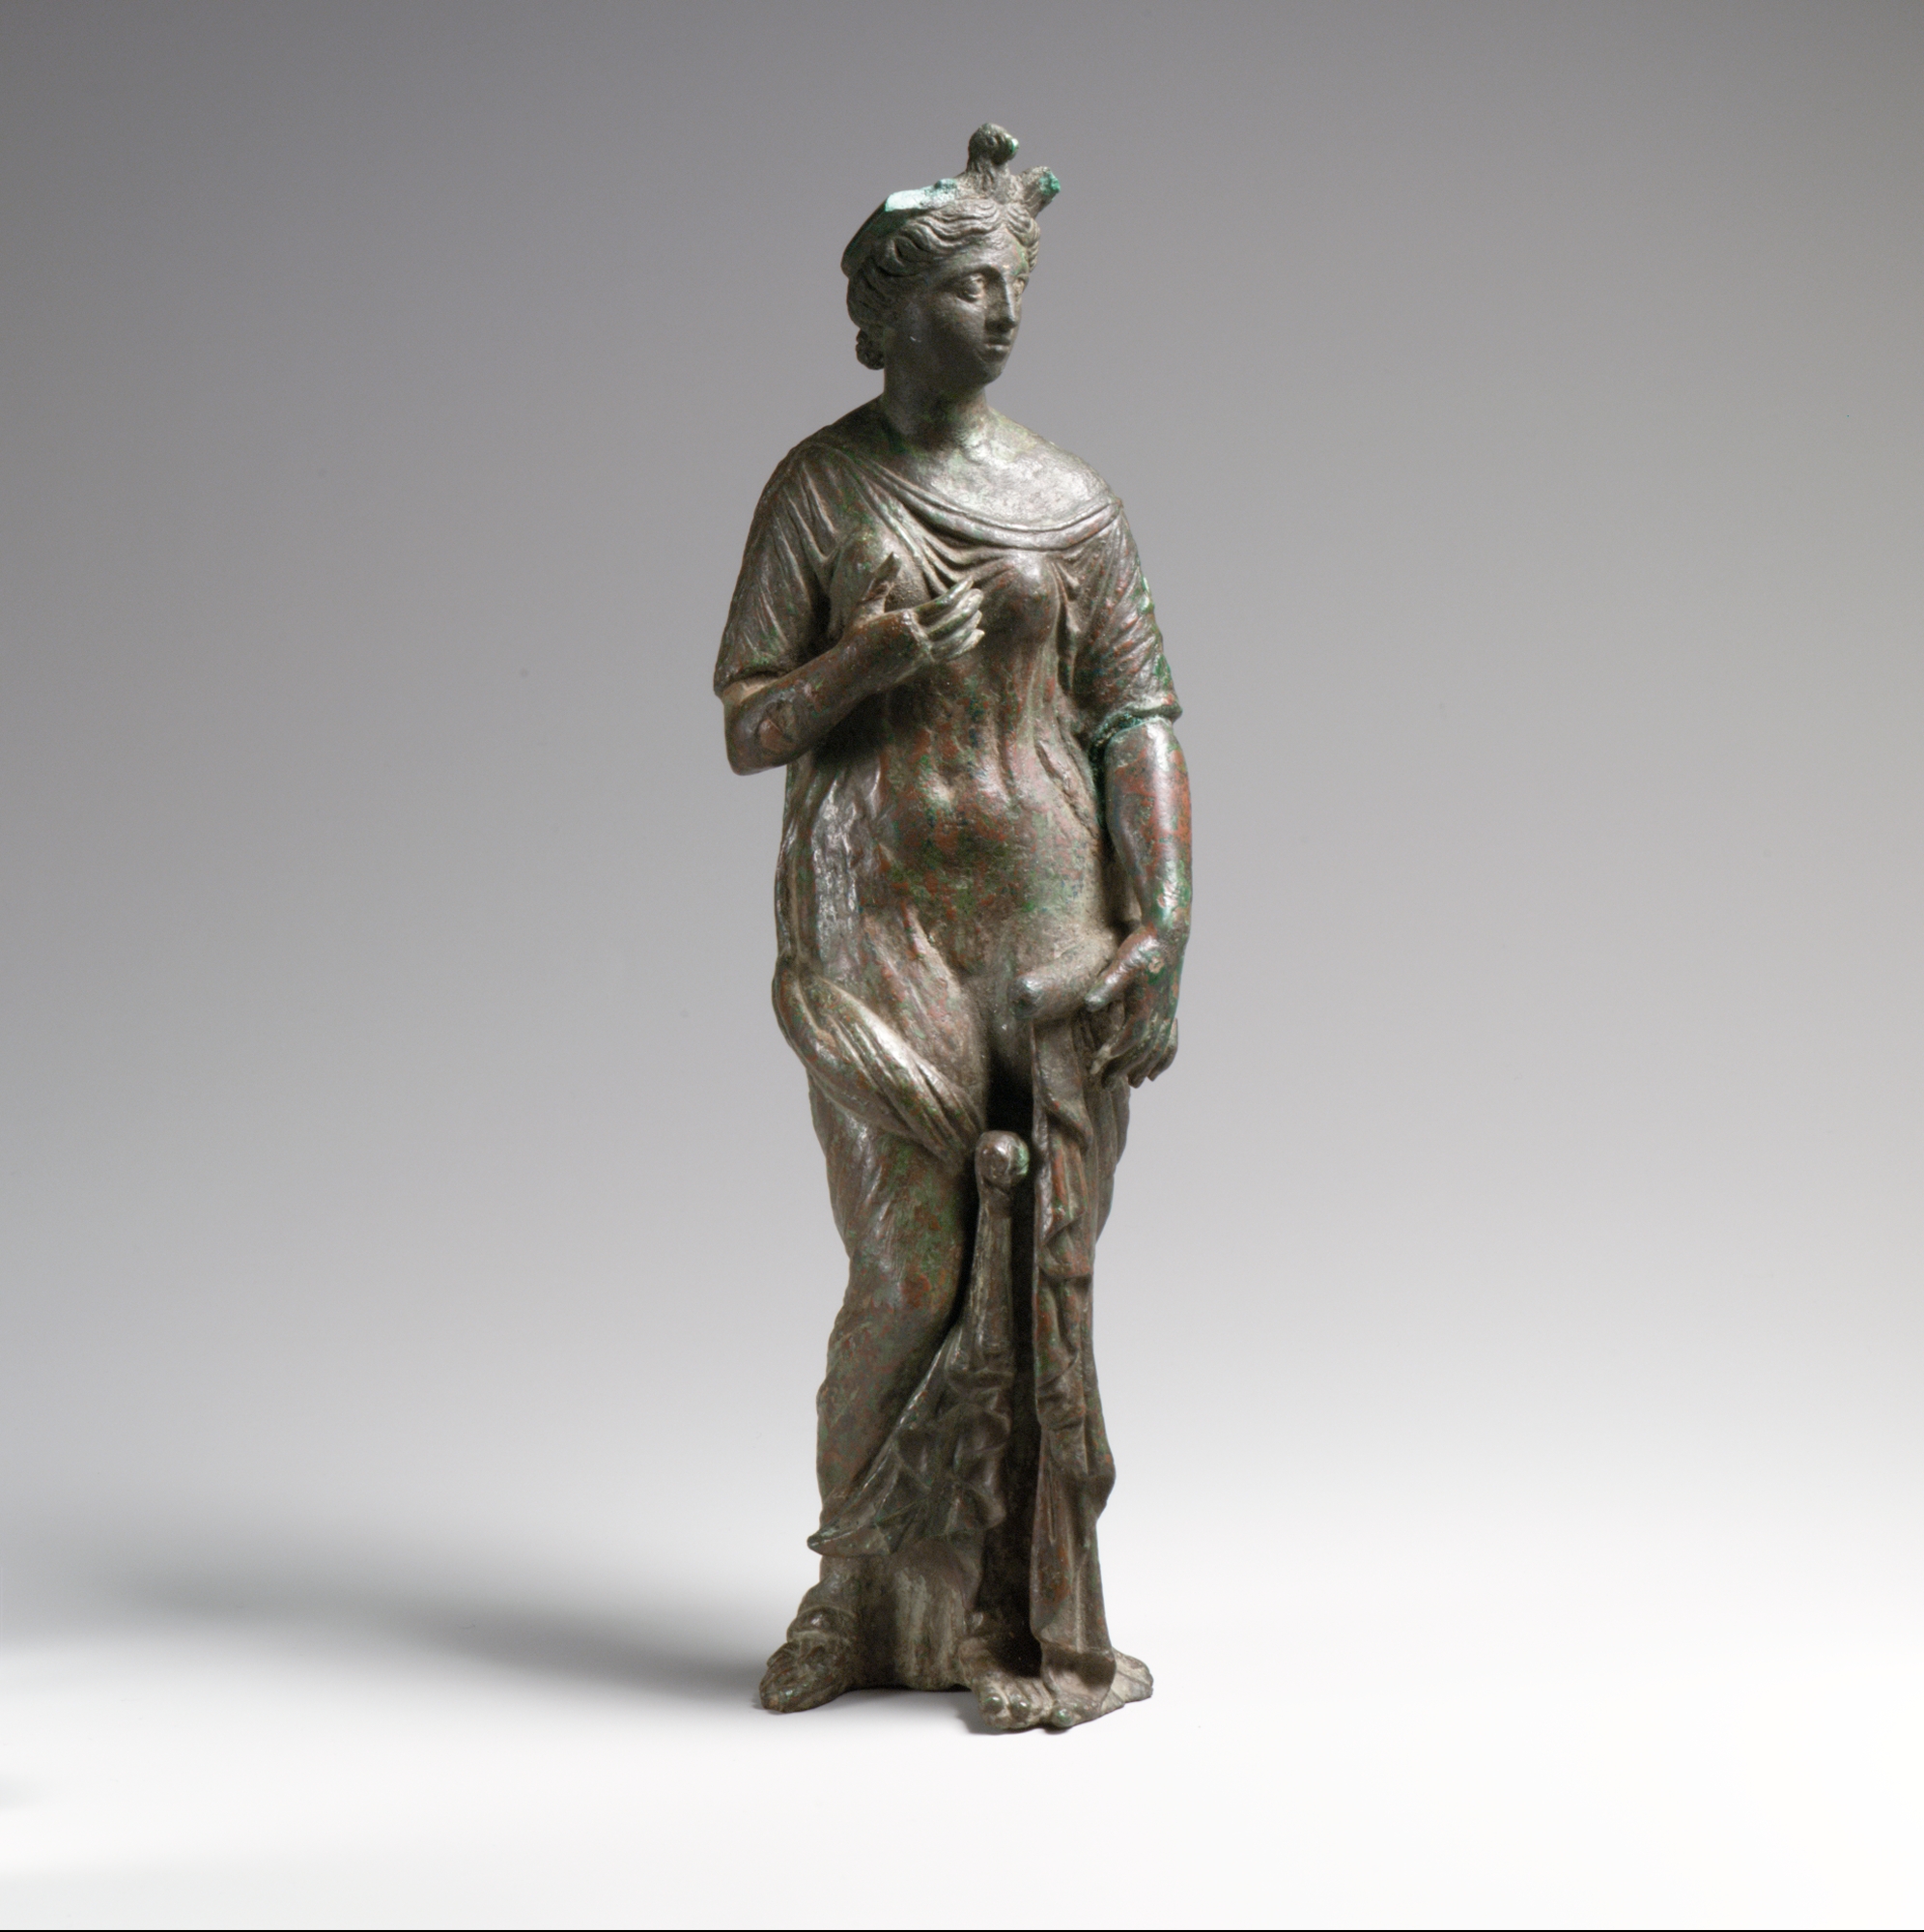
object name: statuette, isi aphrodite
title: Isis-Aphrodite with Egyptian vulture cap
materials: bronze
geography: egypt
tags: aphrodite,goddess